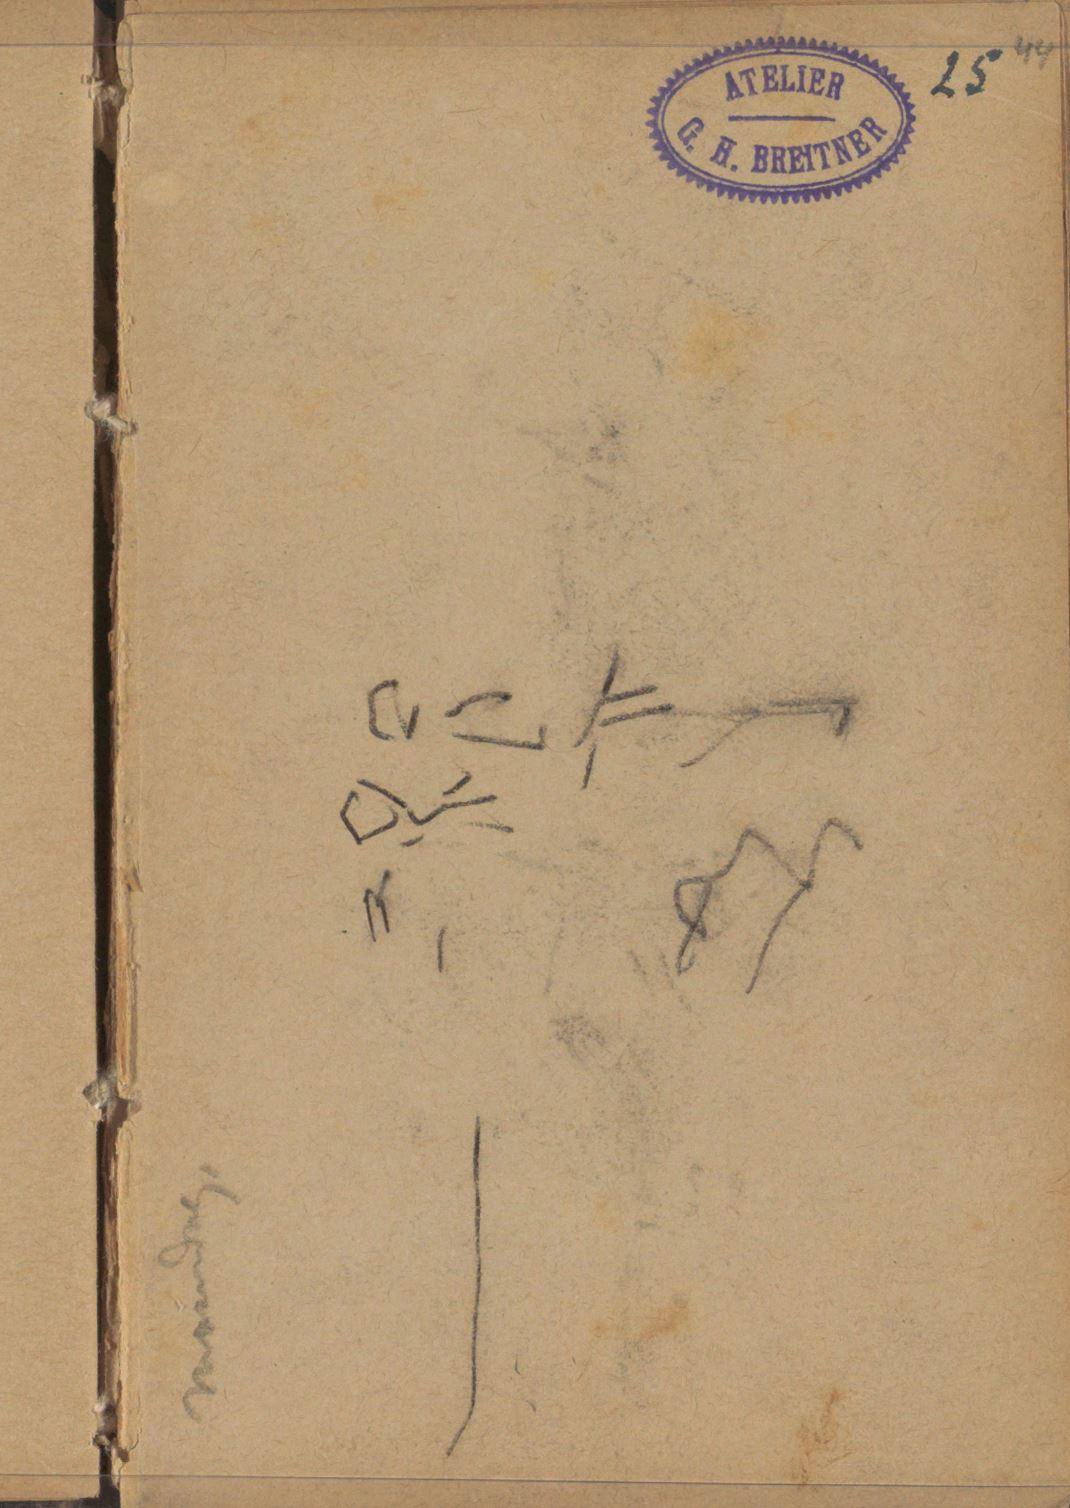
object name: sketchbook leaf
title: Figuurstudies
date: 1887-1891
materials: paper, pencil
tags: adult woman, adult man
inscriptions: workshop stamp: Lugt 291d, annotation: ‘maandag’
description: Pagina 44 uit een schetsboek met 83 bladen.